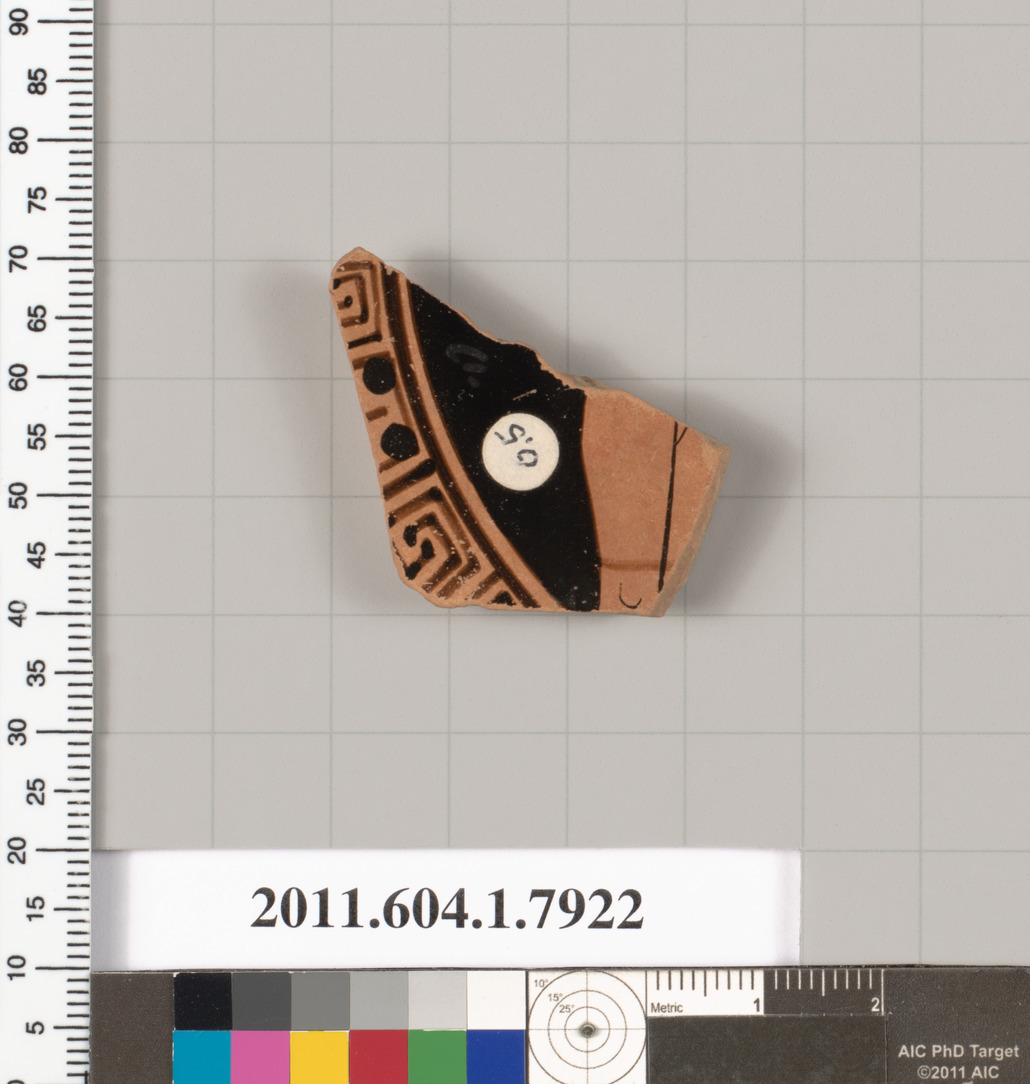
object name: kylix fragment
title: Terracotta fragment of a kylix (drinking cup)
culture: greek, attic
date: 460-450 BCE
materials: terracotta